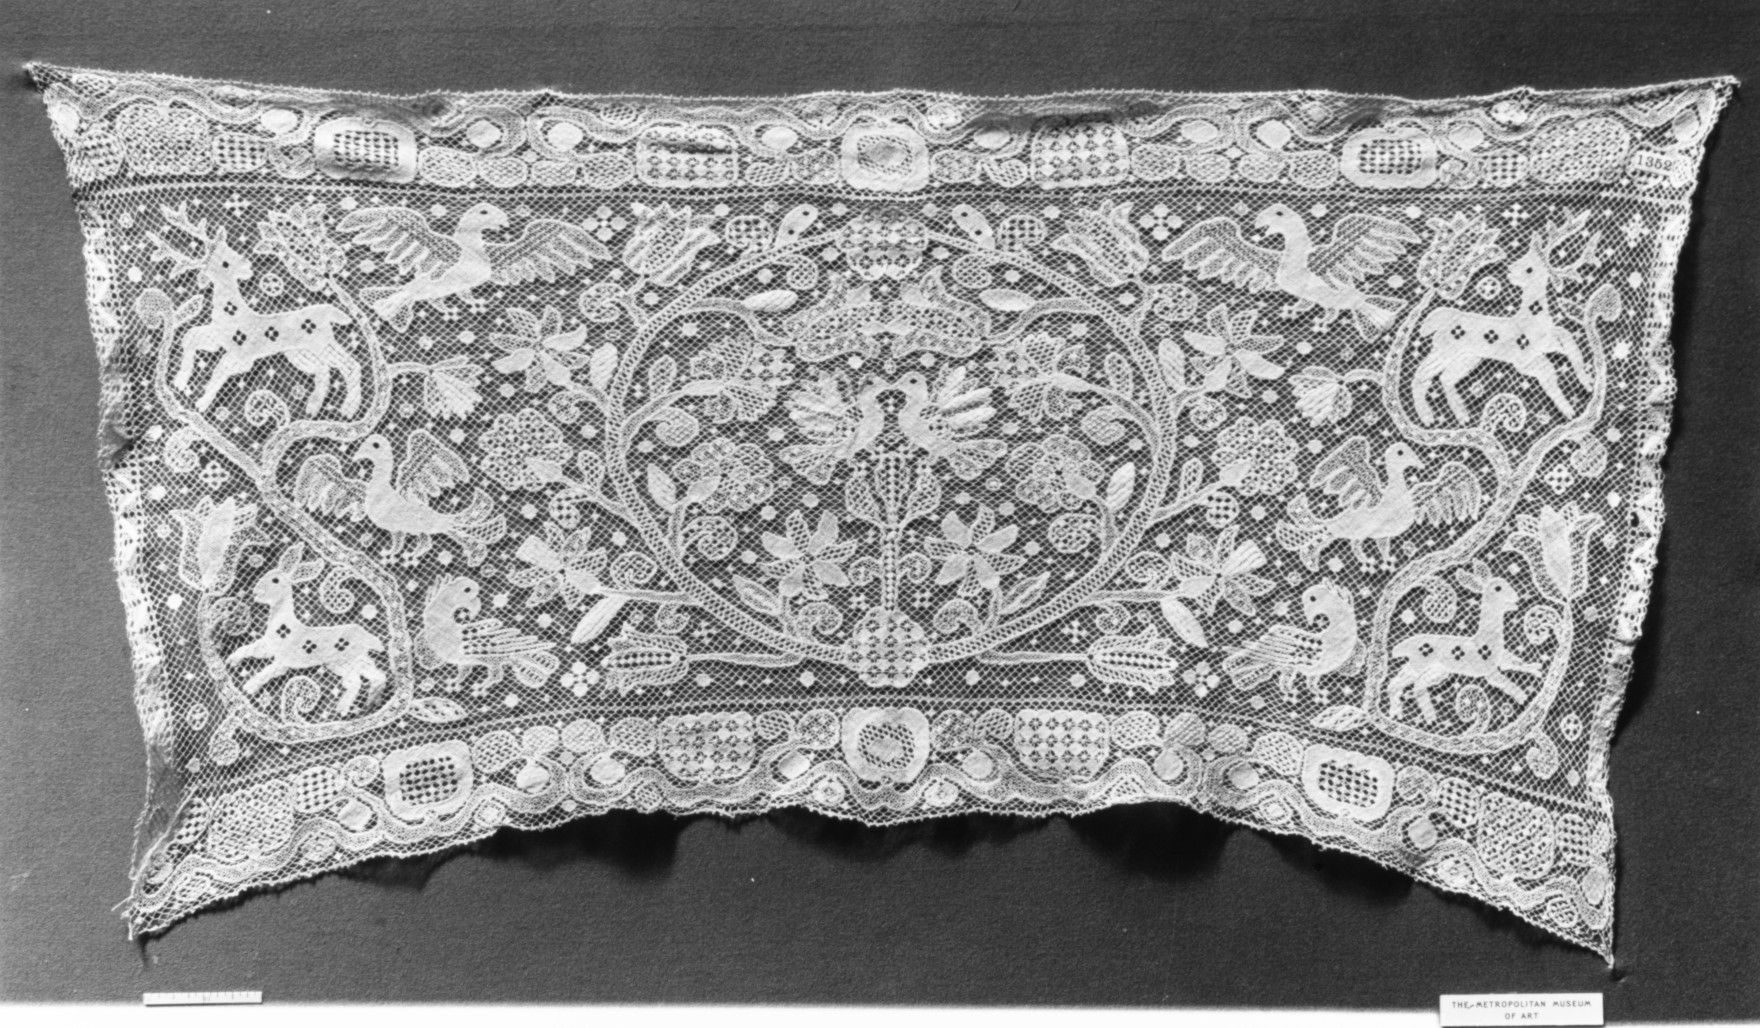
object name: border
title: Border (end of a bridal pillow slip)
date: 1701-1800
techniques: embroidery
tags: birds,flowers